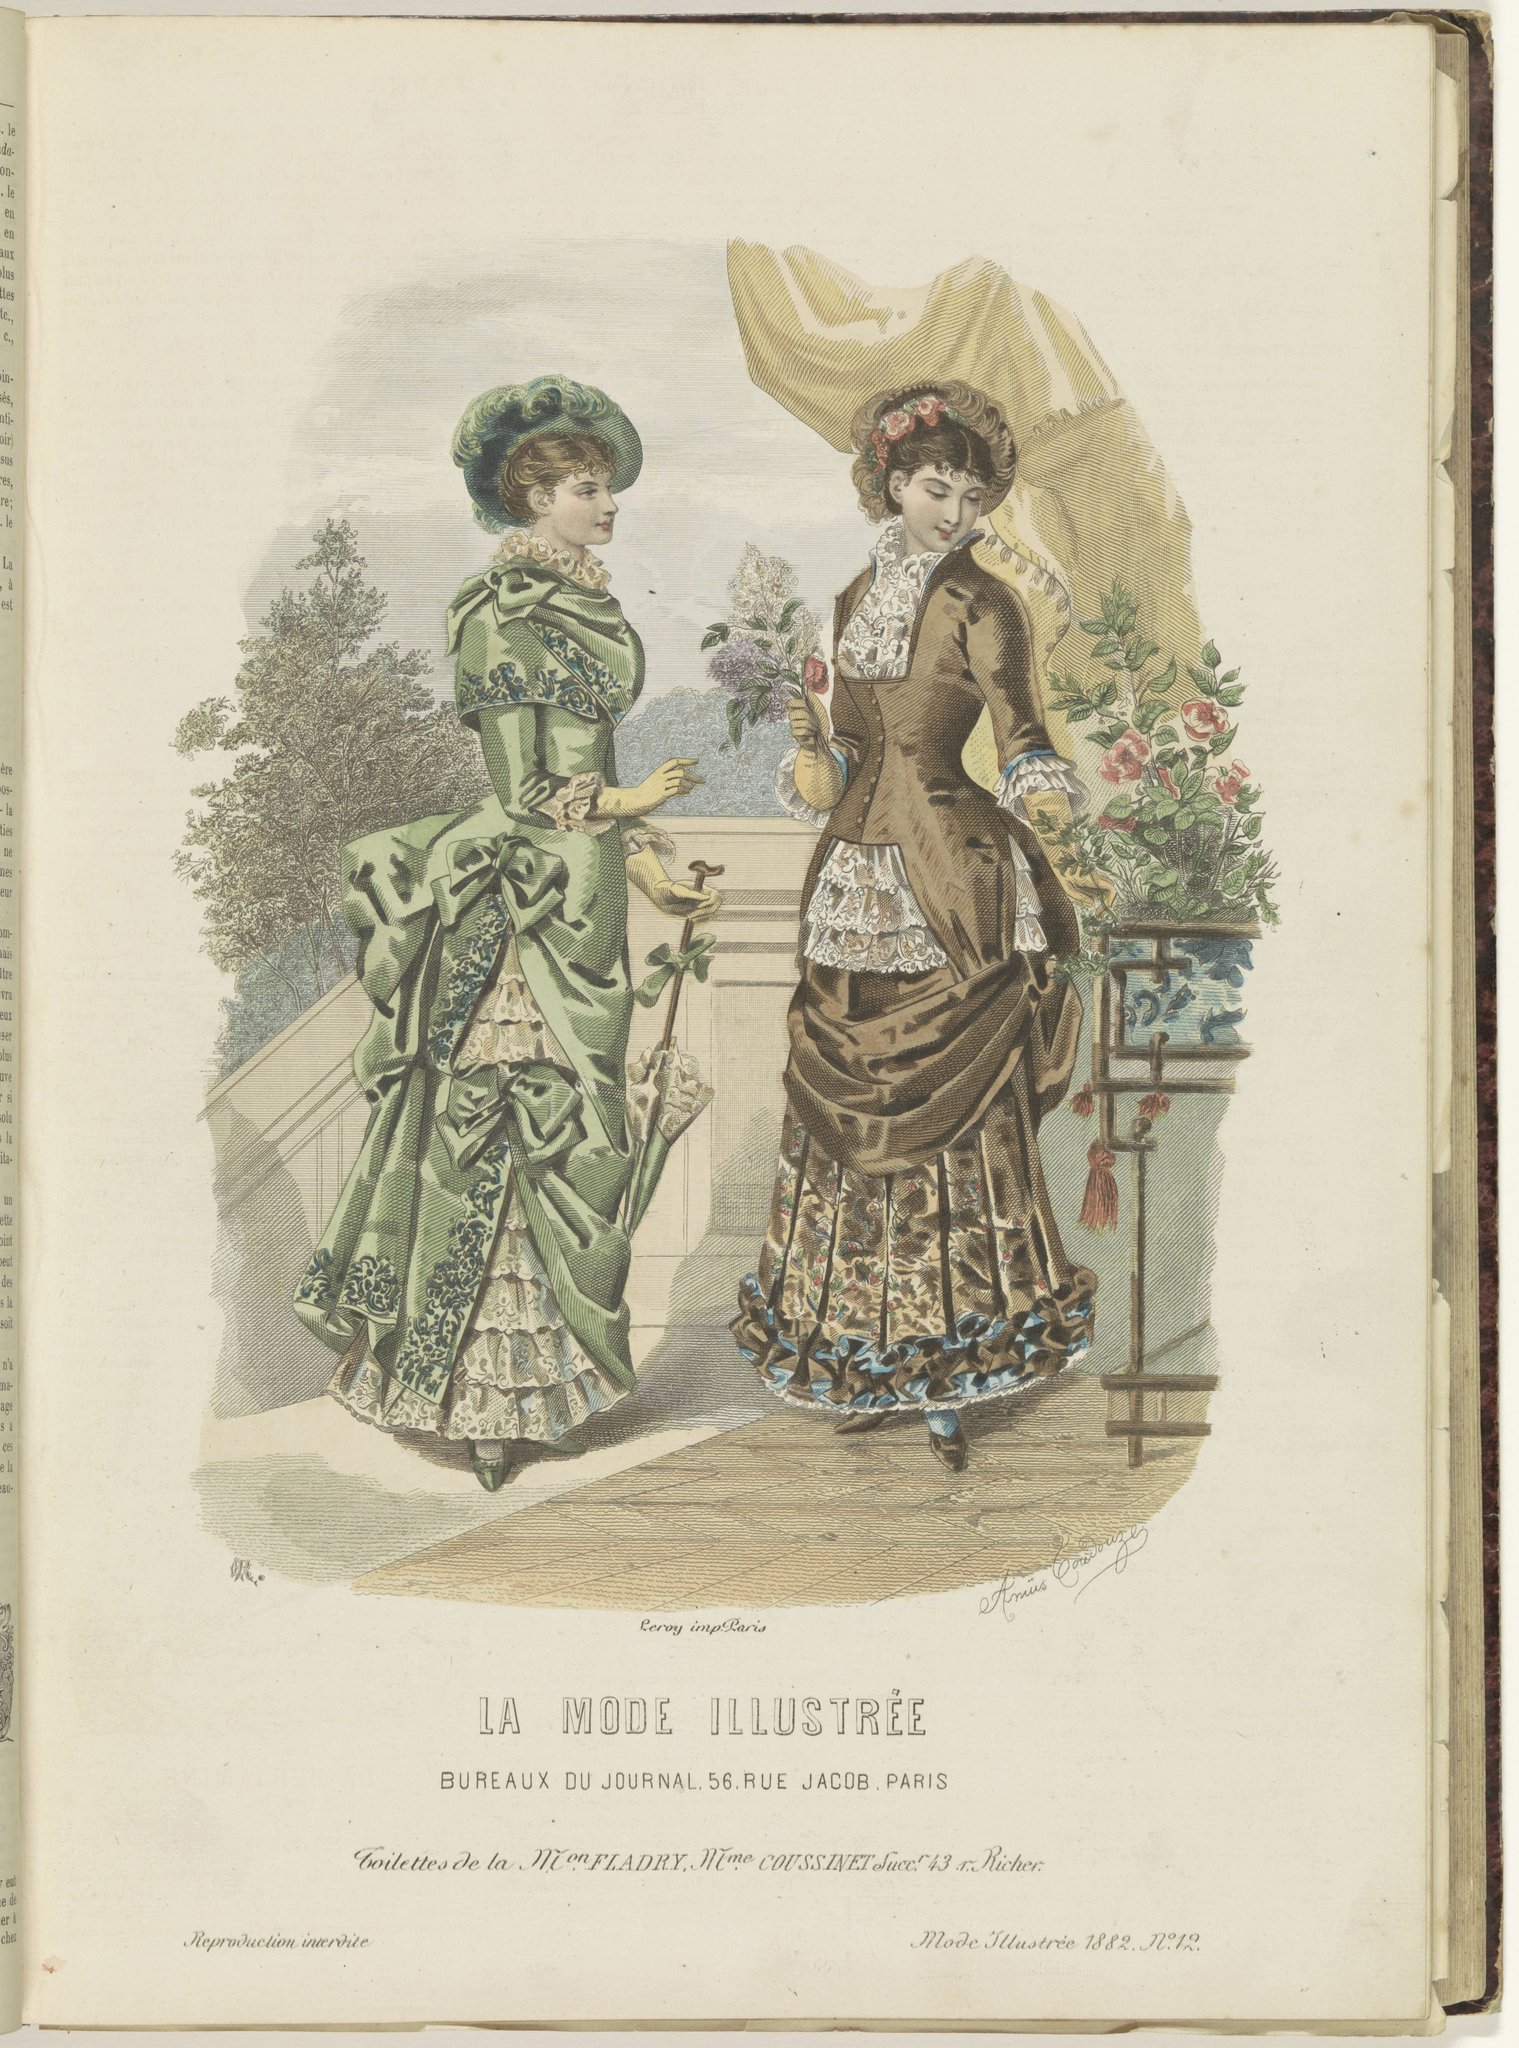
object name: magazine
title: La Mode Illustrée, Journal de la Famille, 1882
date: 1882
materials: paper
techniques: engraving, hand coloring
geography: paris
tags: fashion plates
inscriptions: date